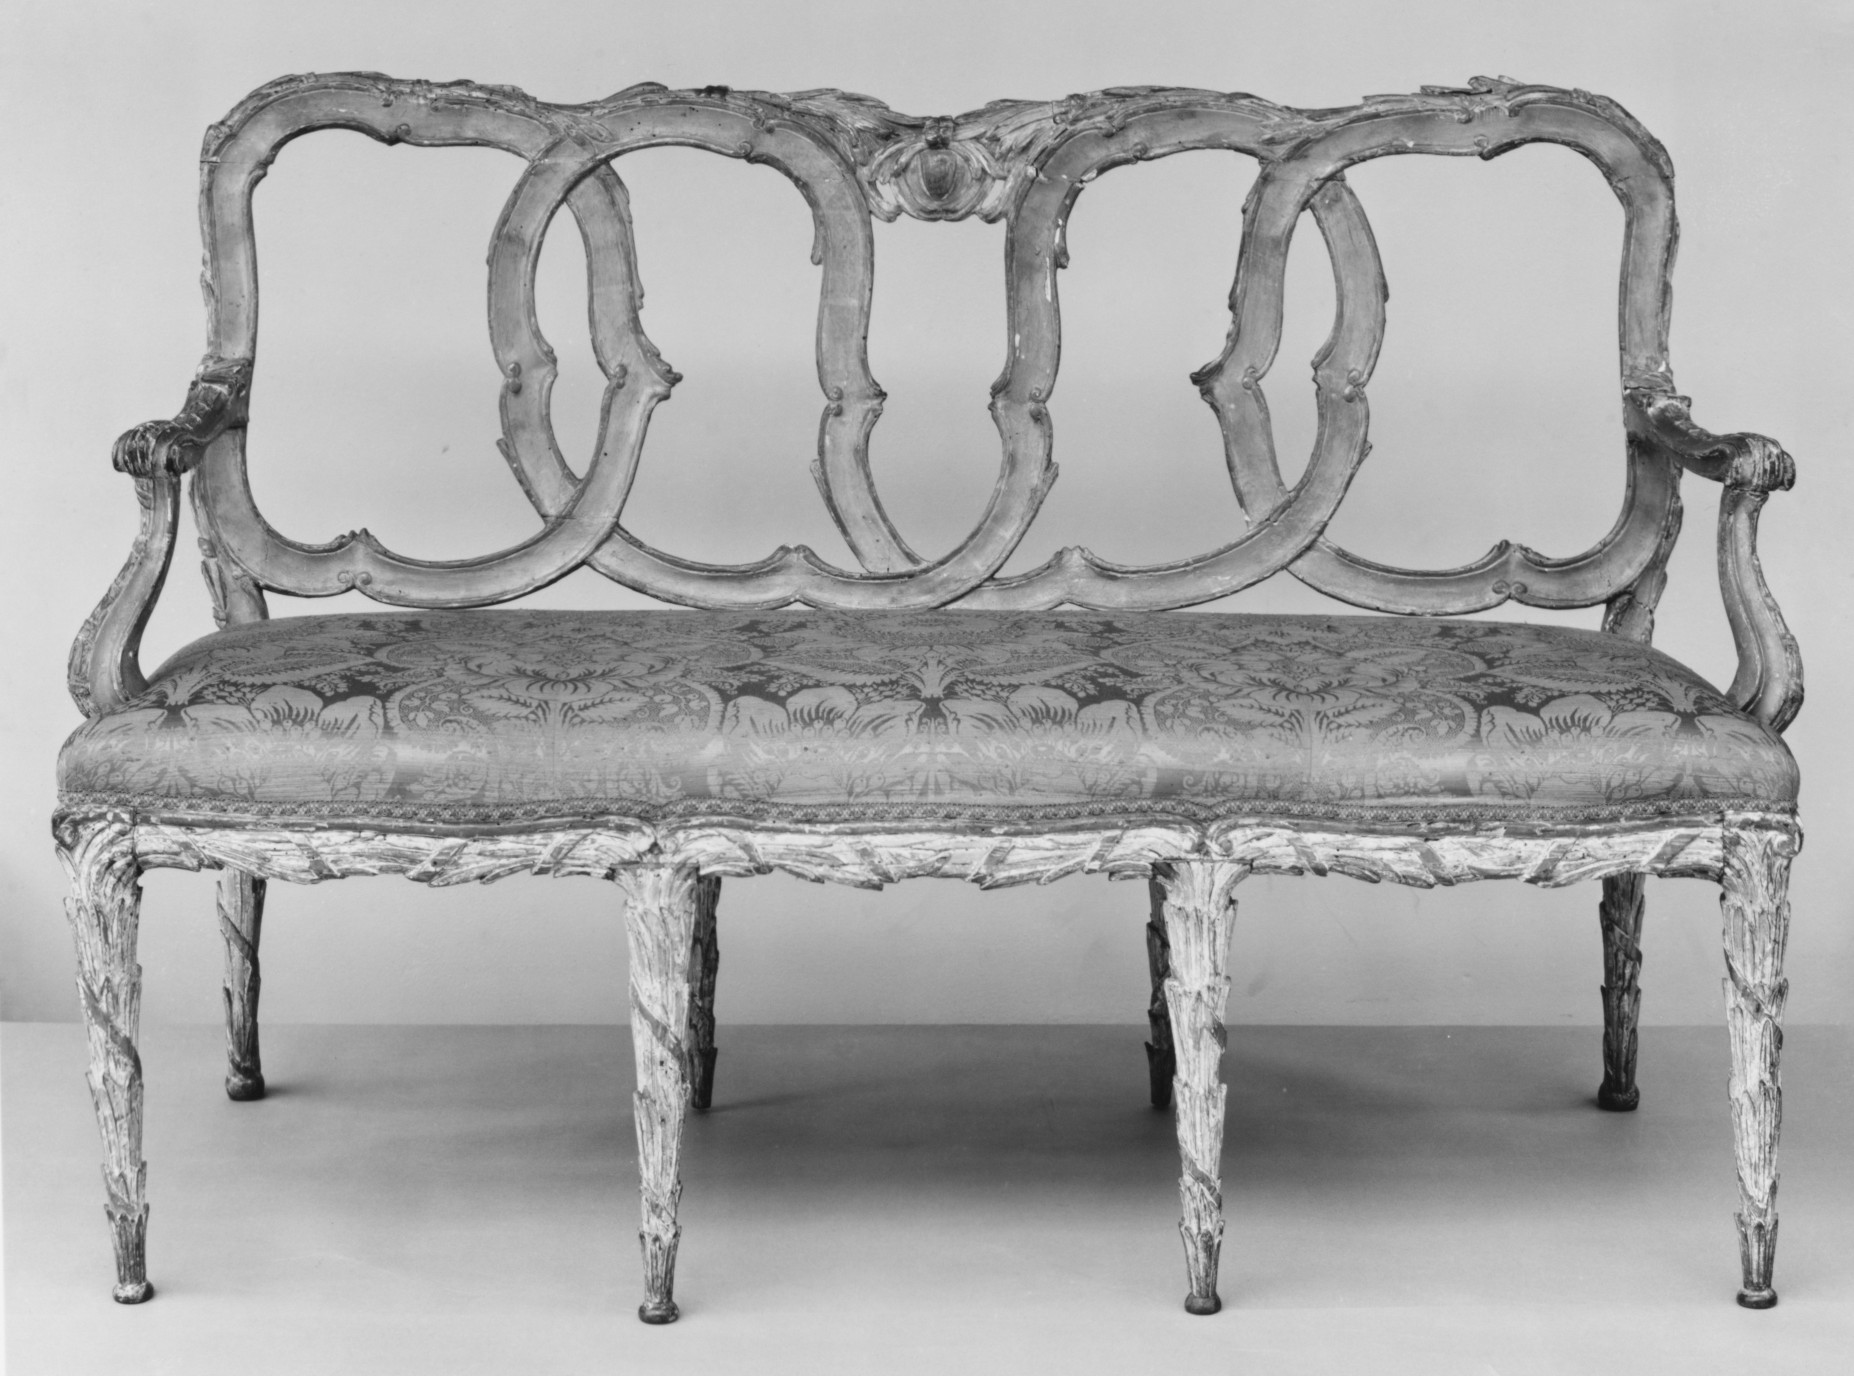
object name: settee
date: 1751-1775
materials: wood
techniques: damask, gilding, painting